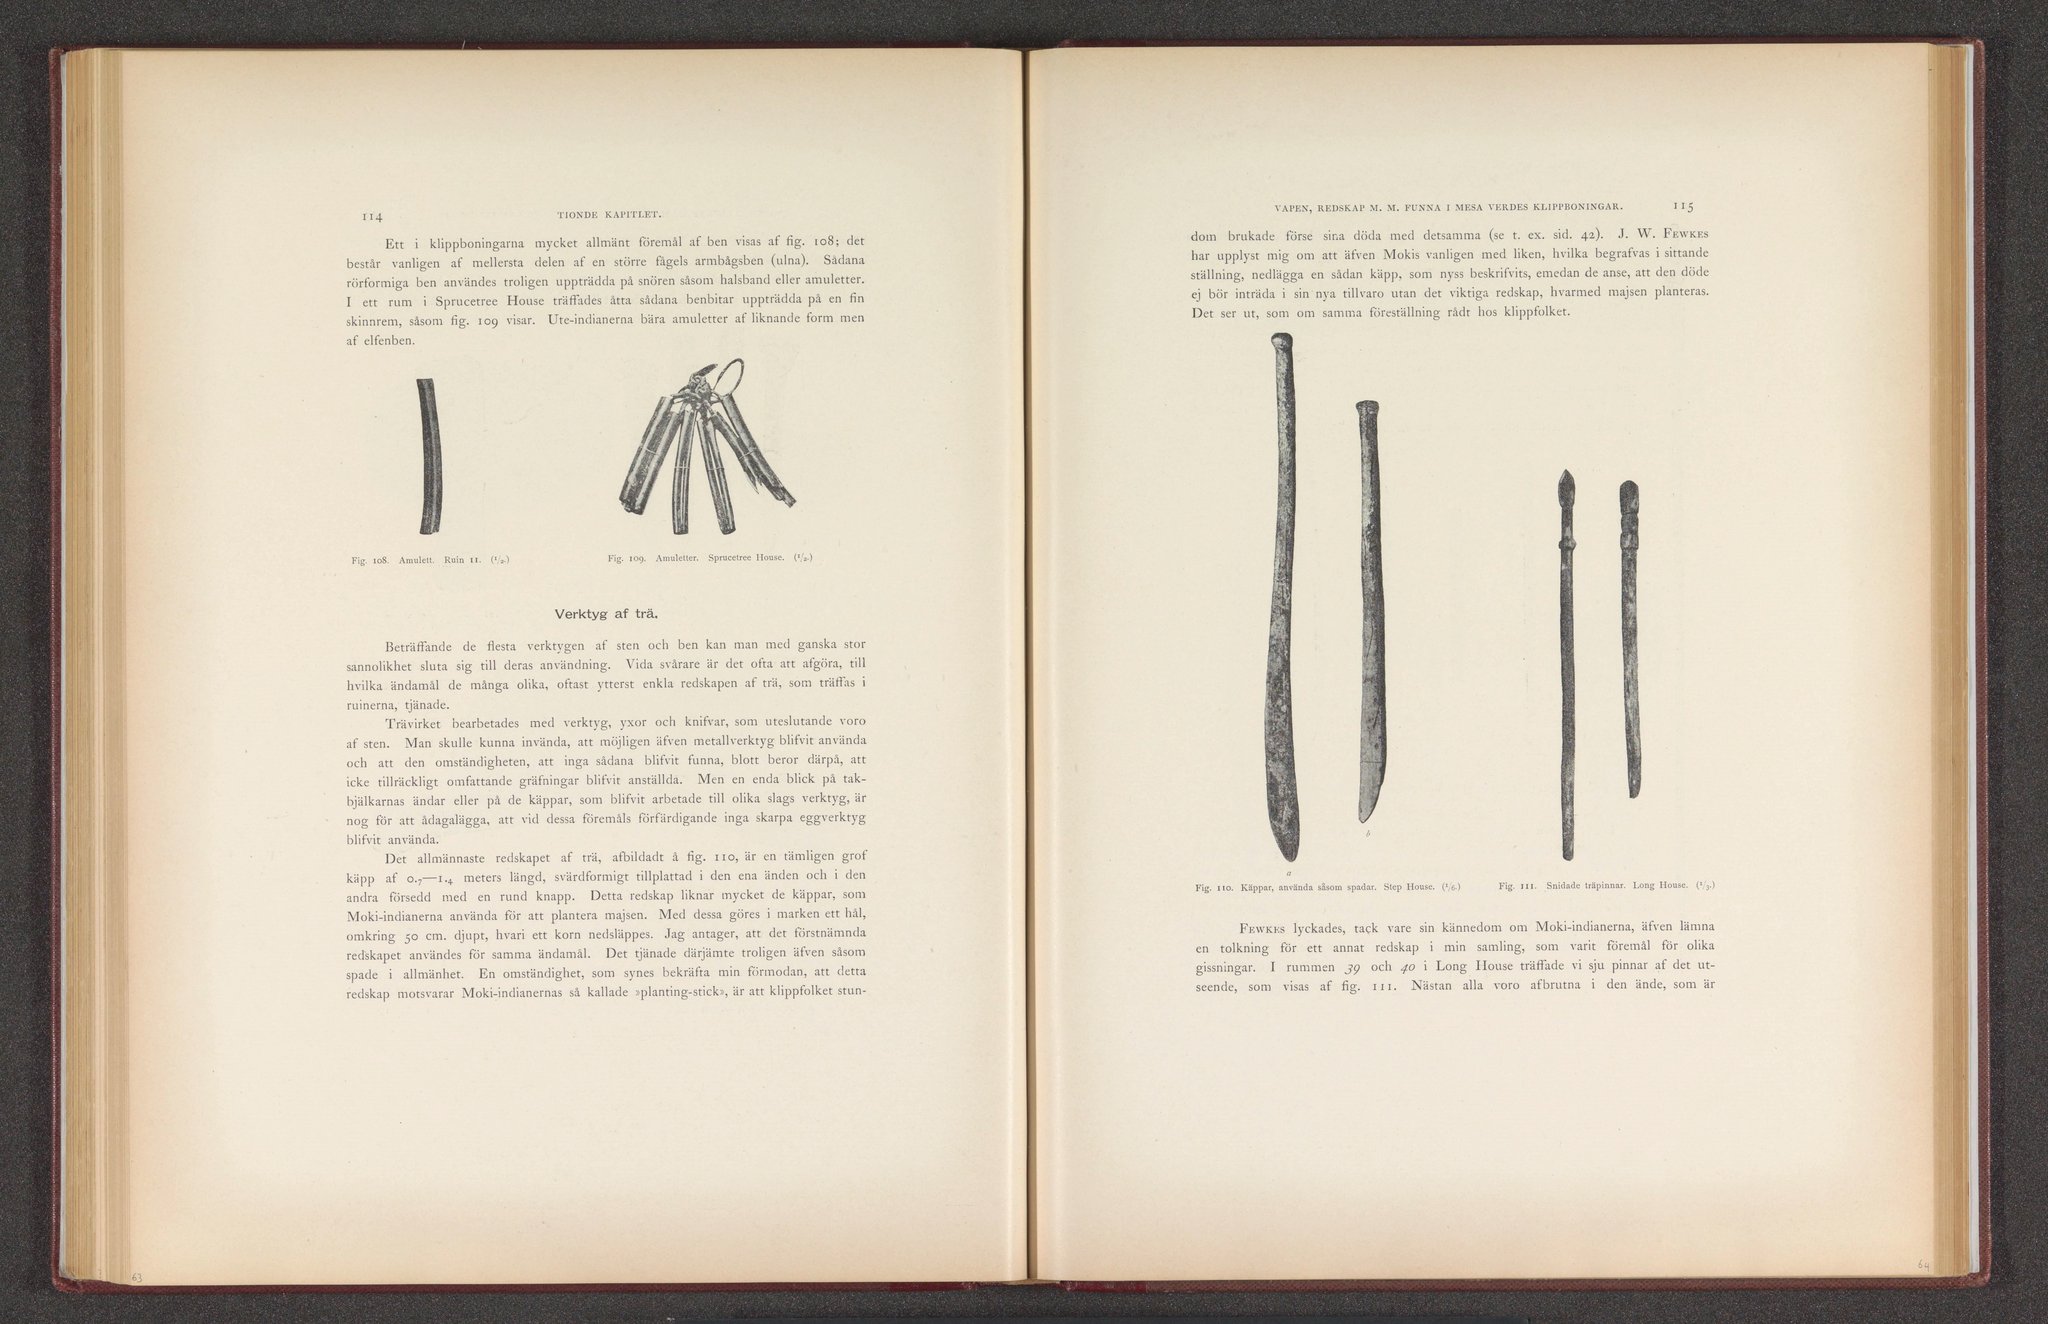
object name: page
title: Gesneden houten stokken die zijn gevonden in het Mesa Verde National Park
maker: gustaf nordenskiöld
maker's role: fotograaf, schrijver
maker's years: 1868-1895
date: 1891-1893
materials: paper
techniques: autotype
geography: vienna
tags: tools, aids, implements ~ crafts and industries (+ twigs ~ crafts, industries, agriculture)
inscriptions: number: ‘Fig. 110. Fig. 111.’